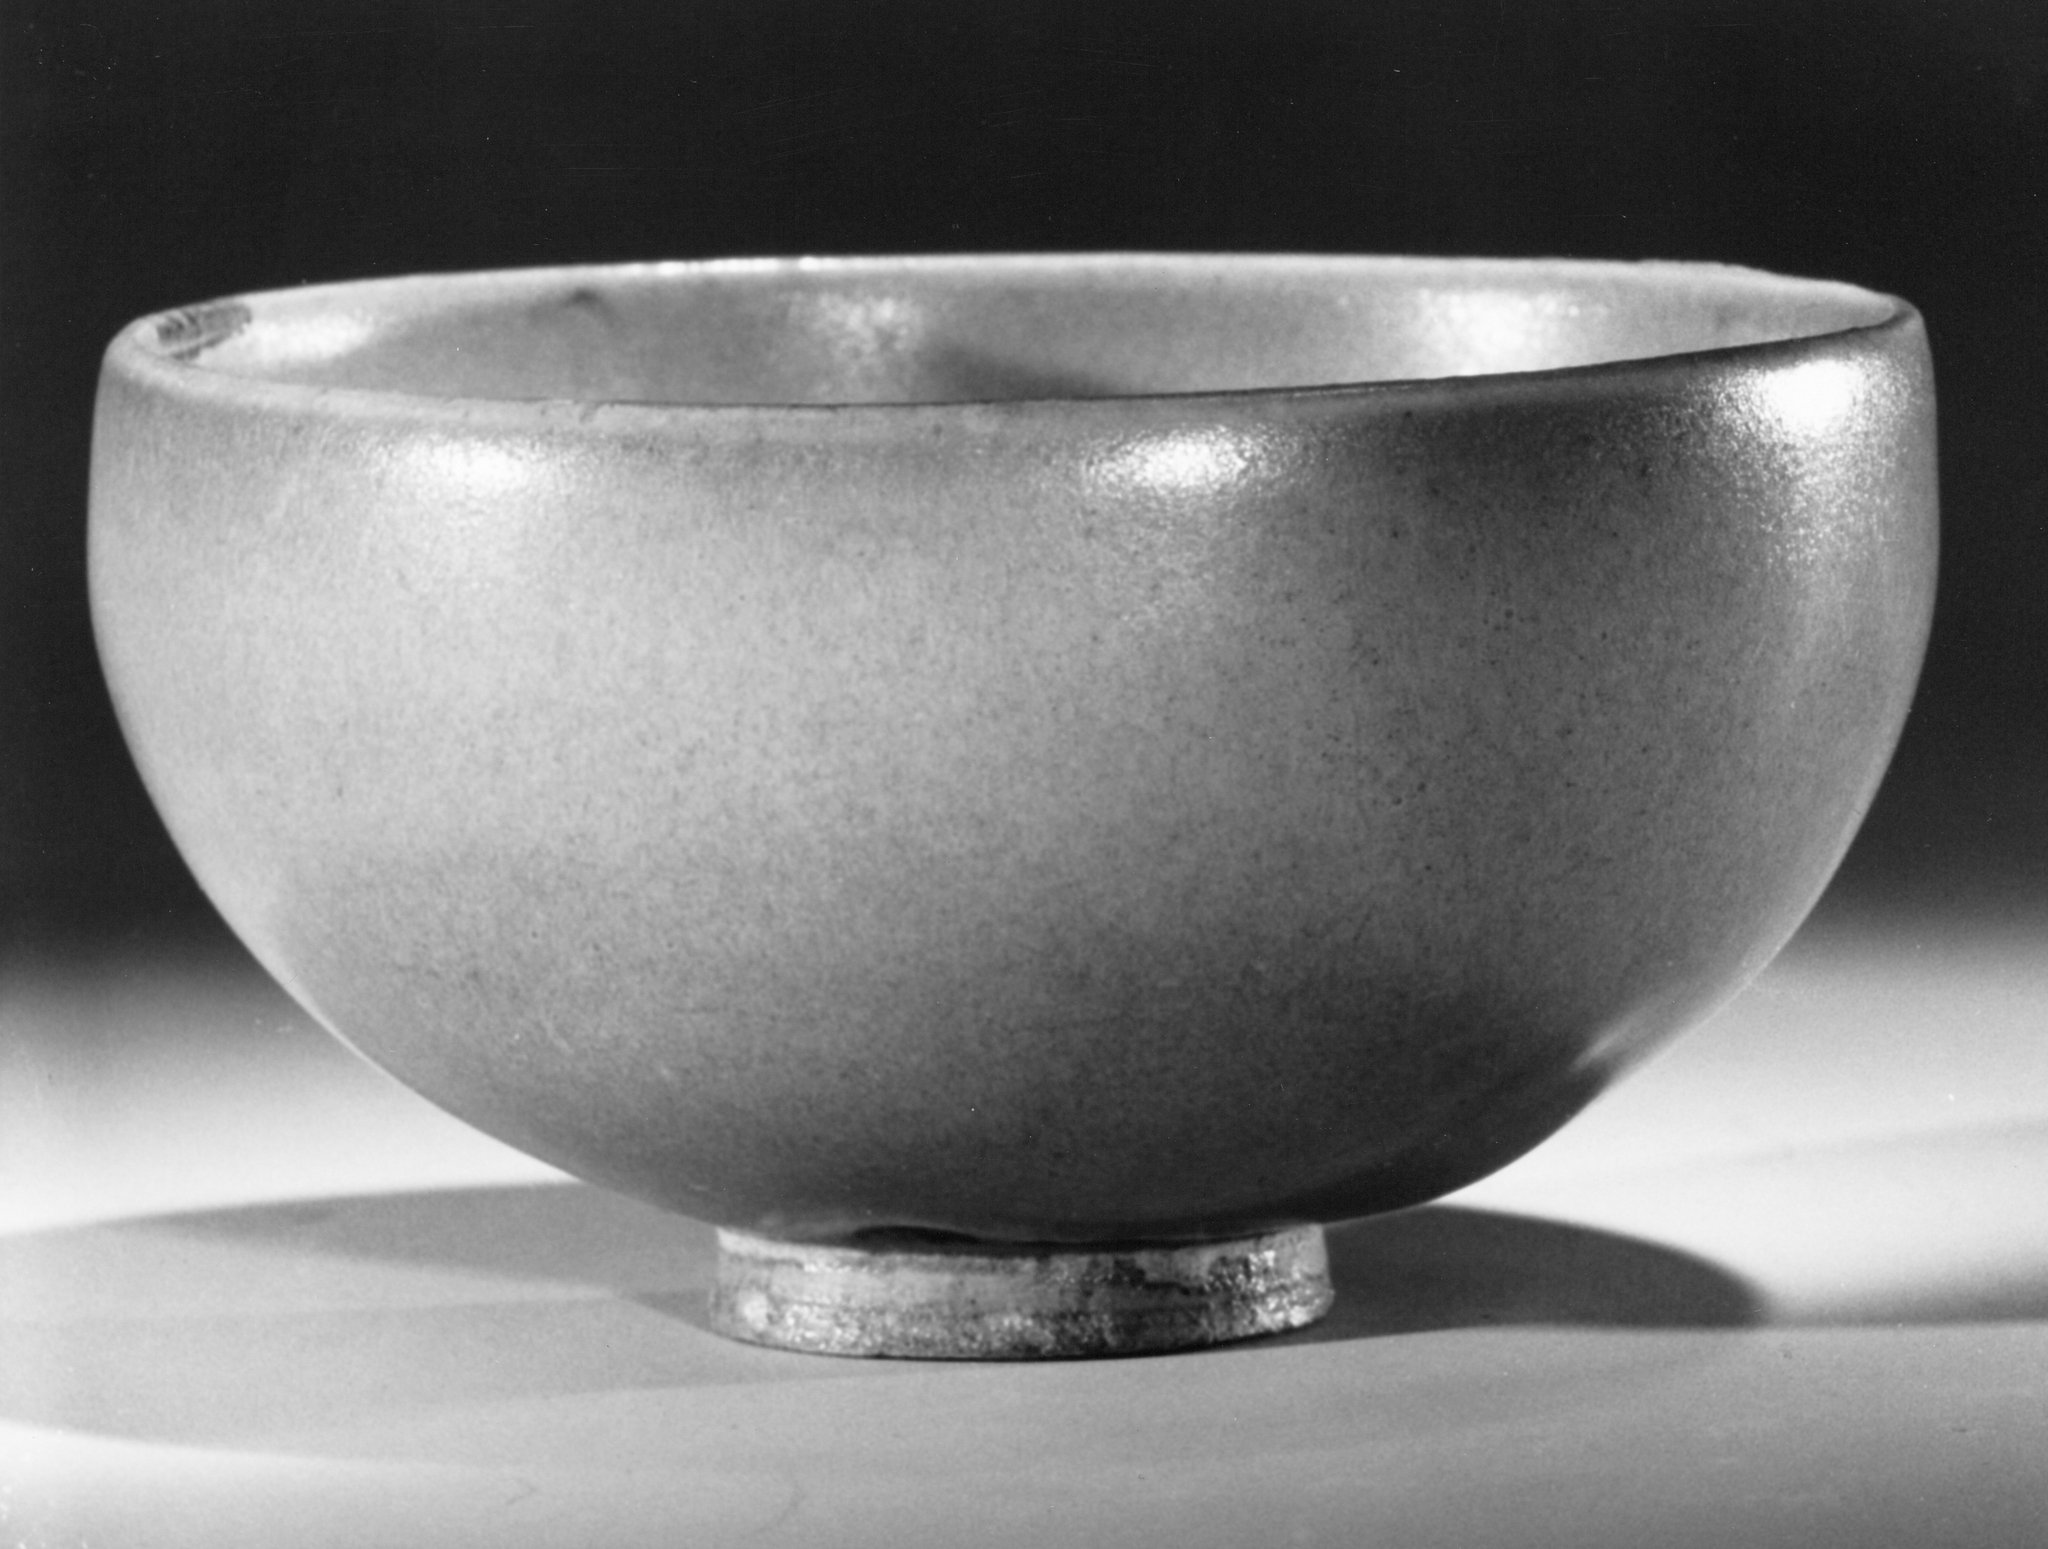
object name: small bowl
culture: chinese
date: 1115-1234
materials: glaze, stoneware